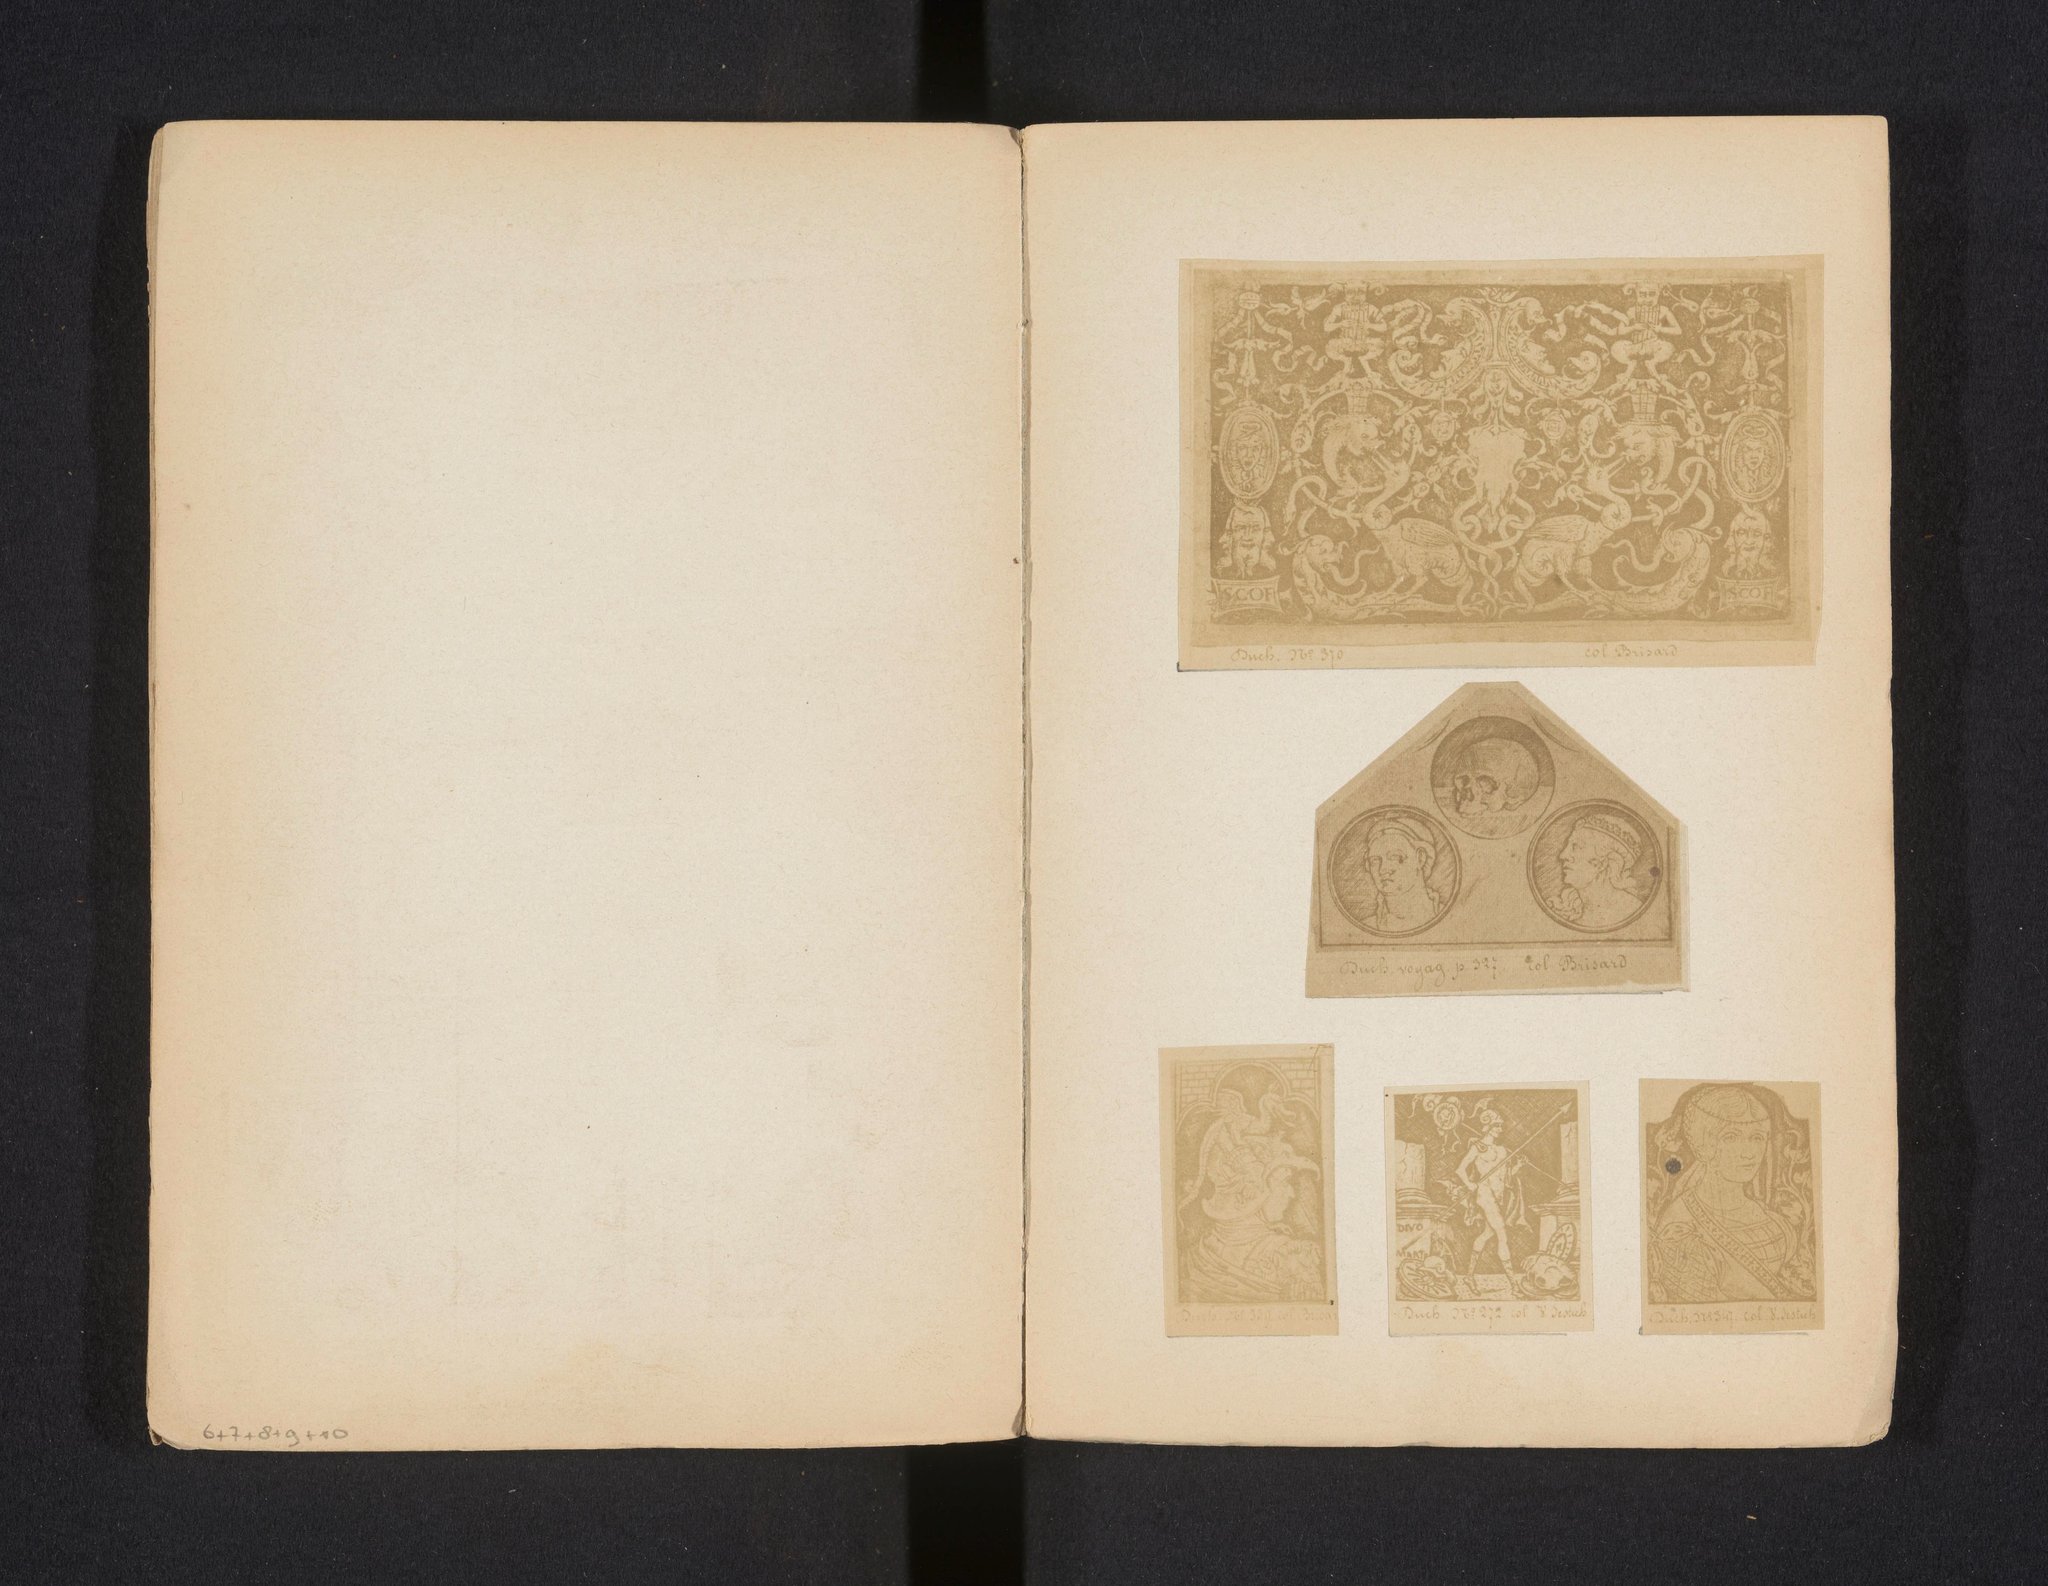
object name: page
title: Fotoreproductie van een prent van een krijger met een trofee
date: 1853-1858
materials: photographic support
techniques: salted paper print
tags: adult man, trophy ~ battle, war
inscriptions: inscription: ‘Duch. No 272. col. V. Sestich’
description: Foto op vijfde ongenummerde pagina na pagina 142.